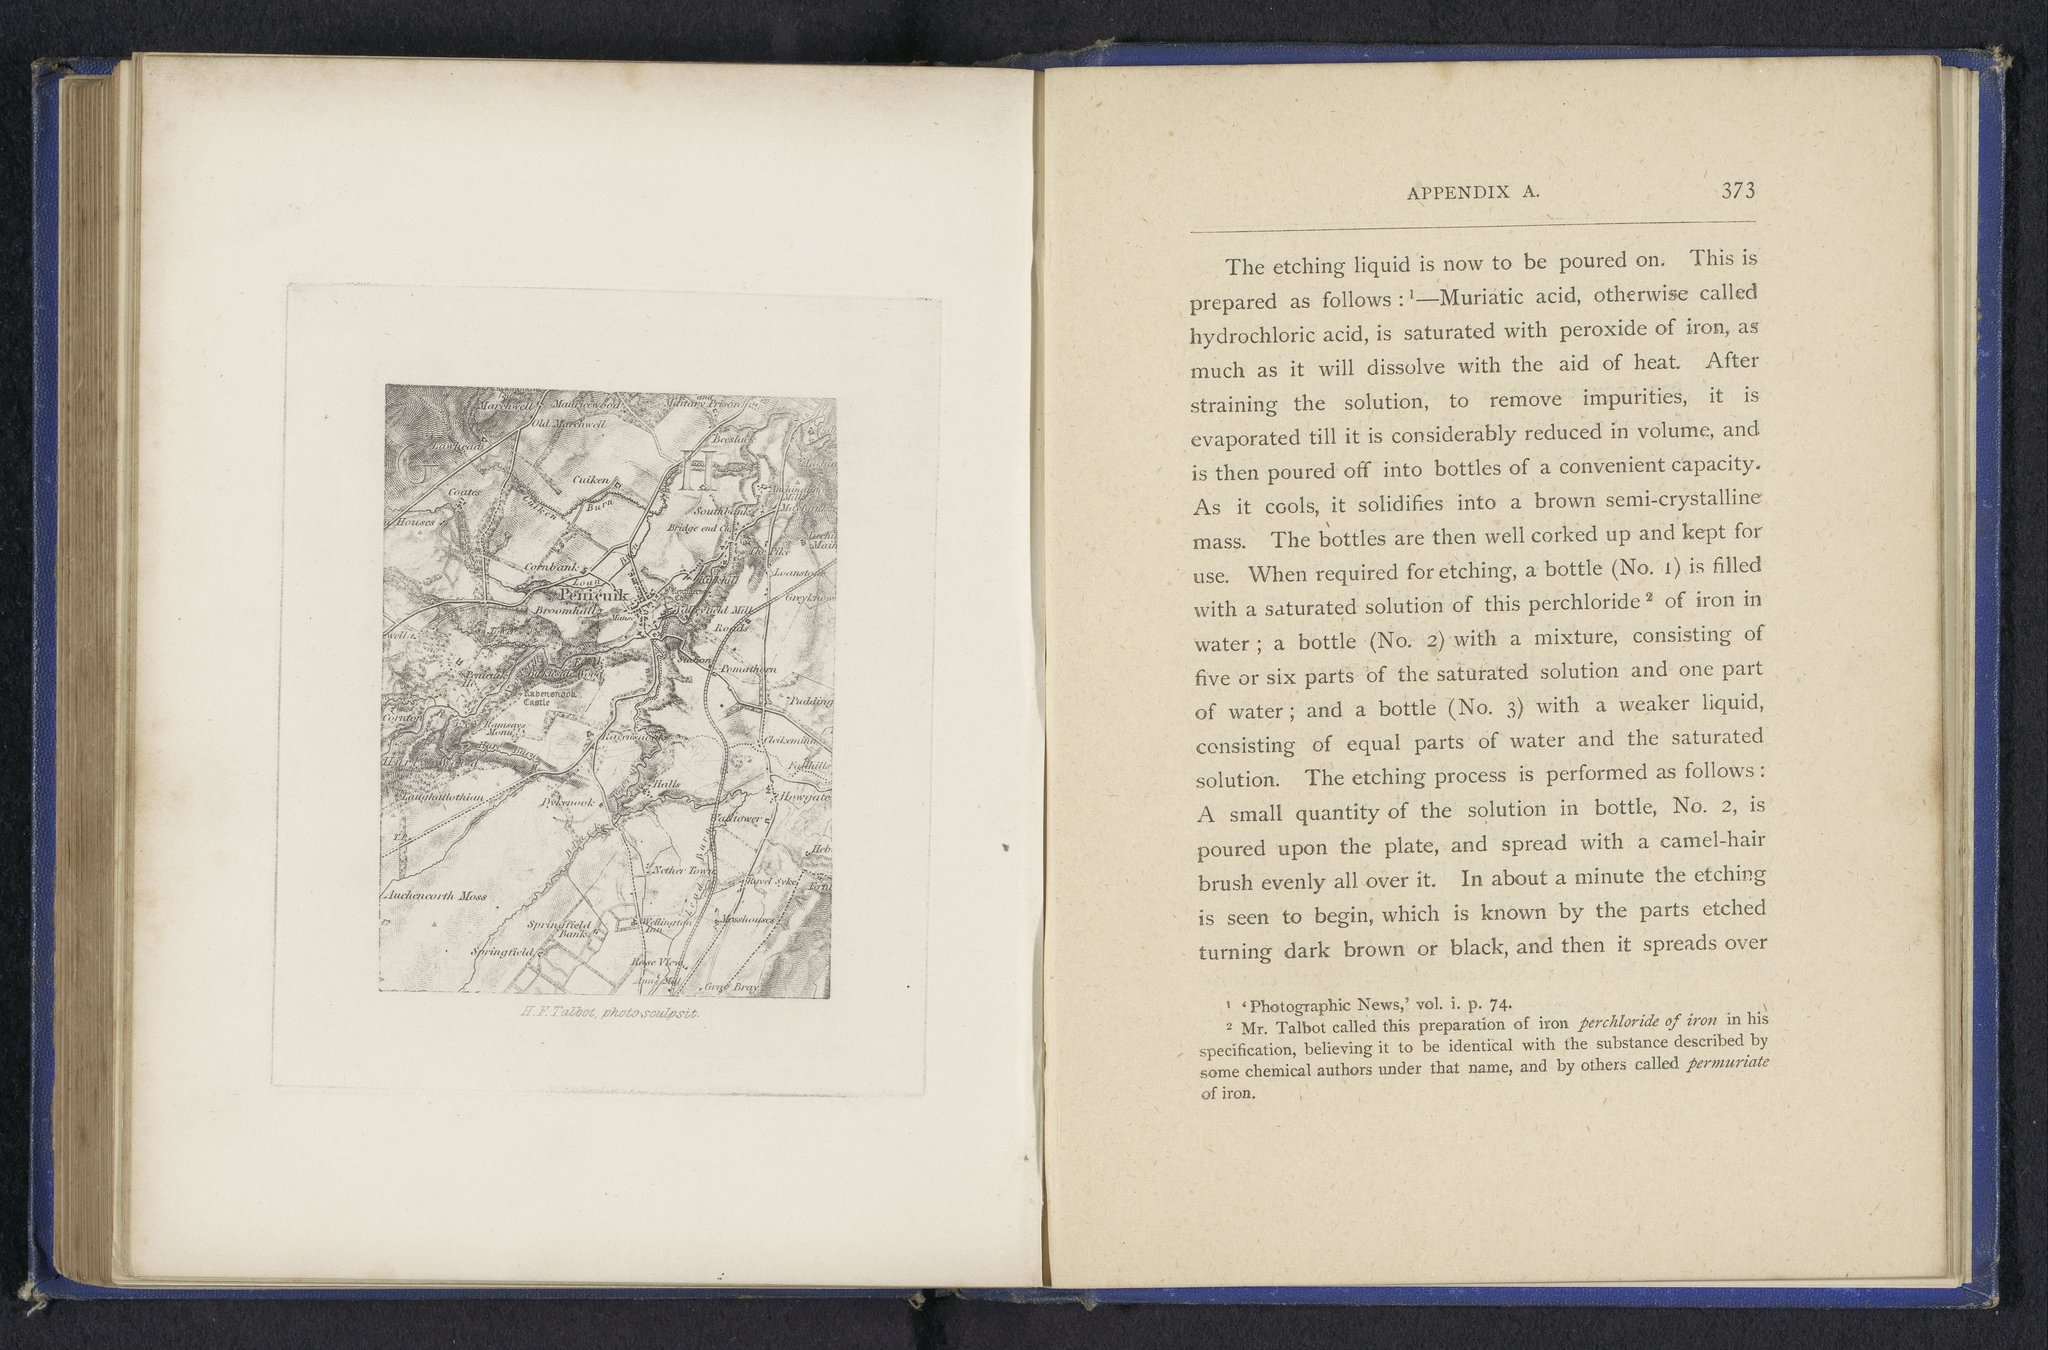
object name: reproduction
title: Fotoreproductie van een prent, voorstellende een kaart van Penicuik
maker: william henry fox talbot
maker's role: fotograaf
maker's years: 1800-1877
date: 1868-1878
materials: paper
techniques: etching, photoglyphic engraving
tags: maps of separate countries or regions